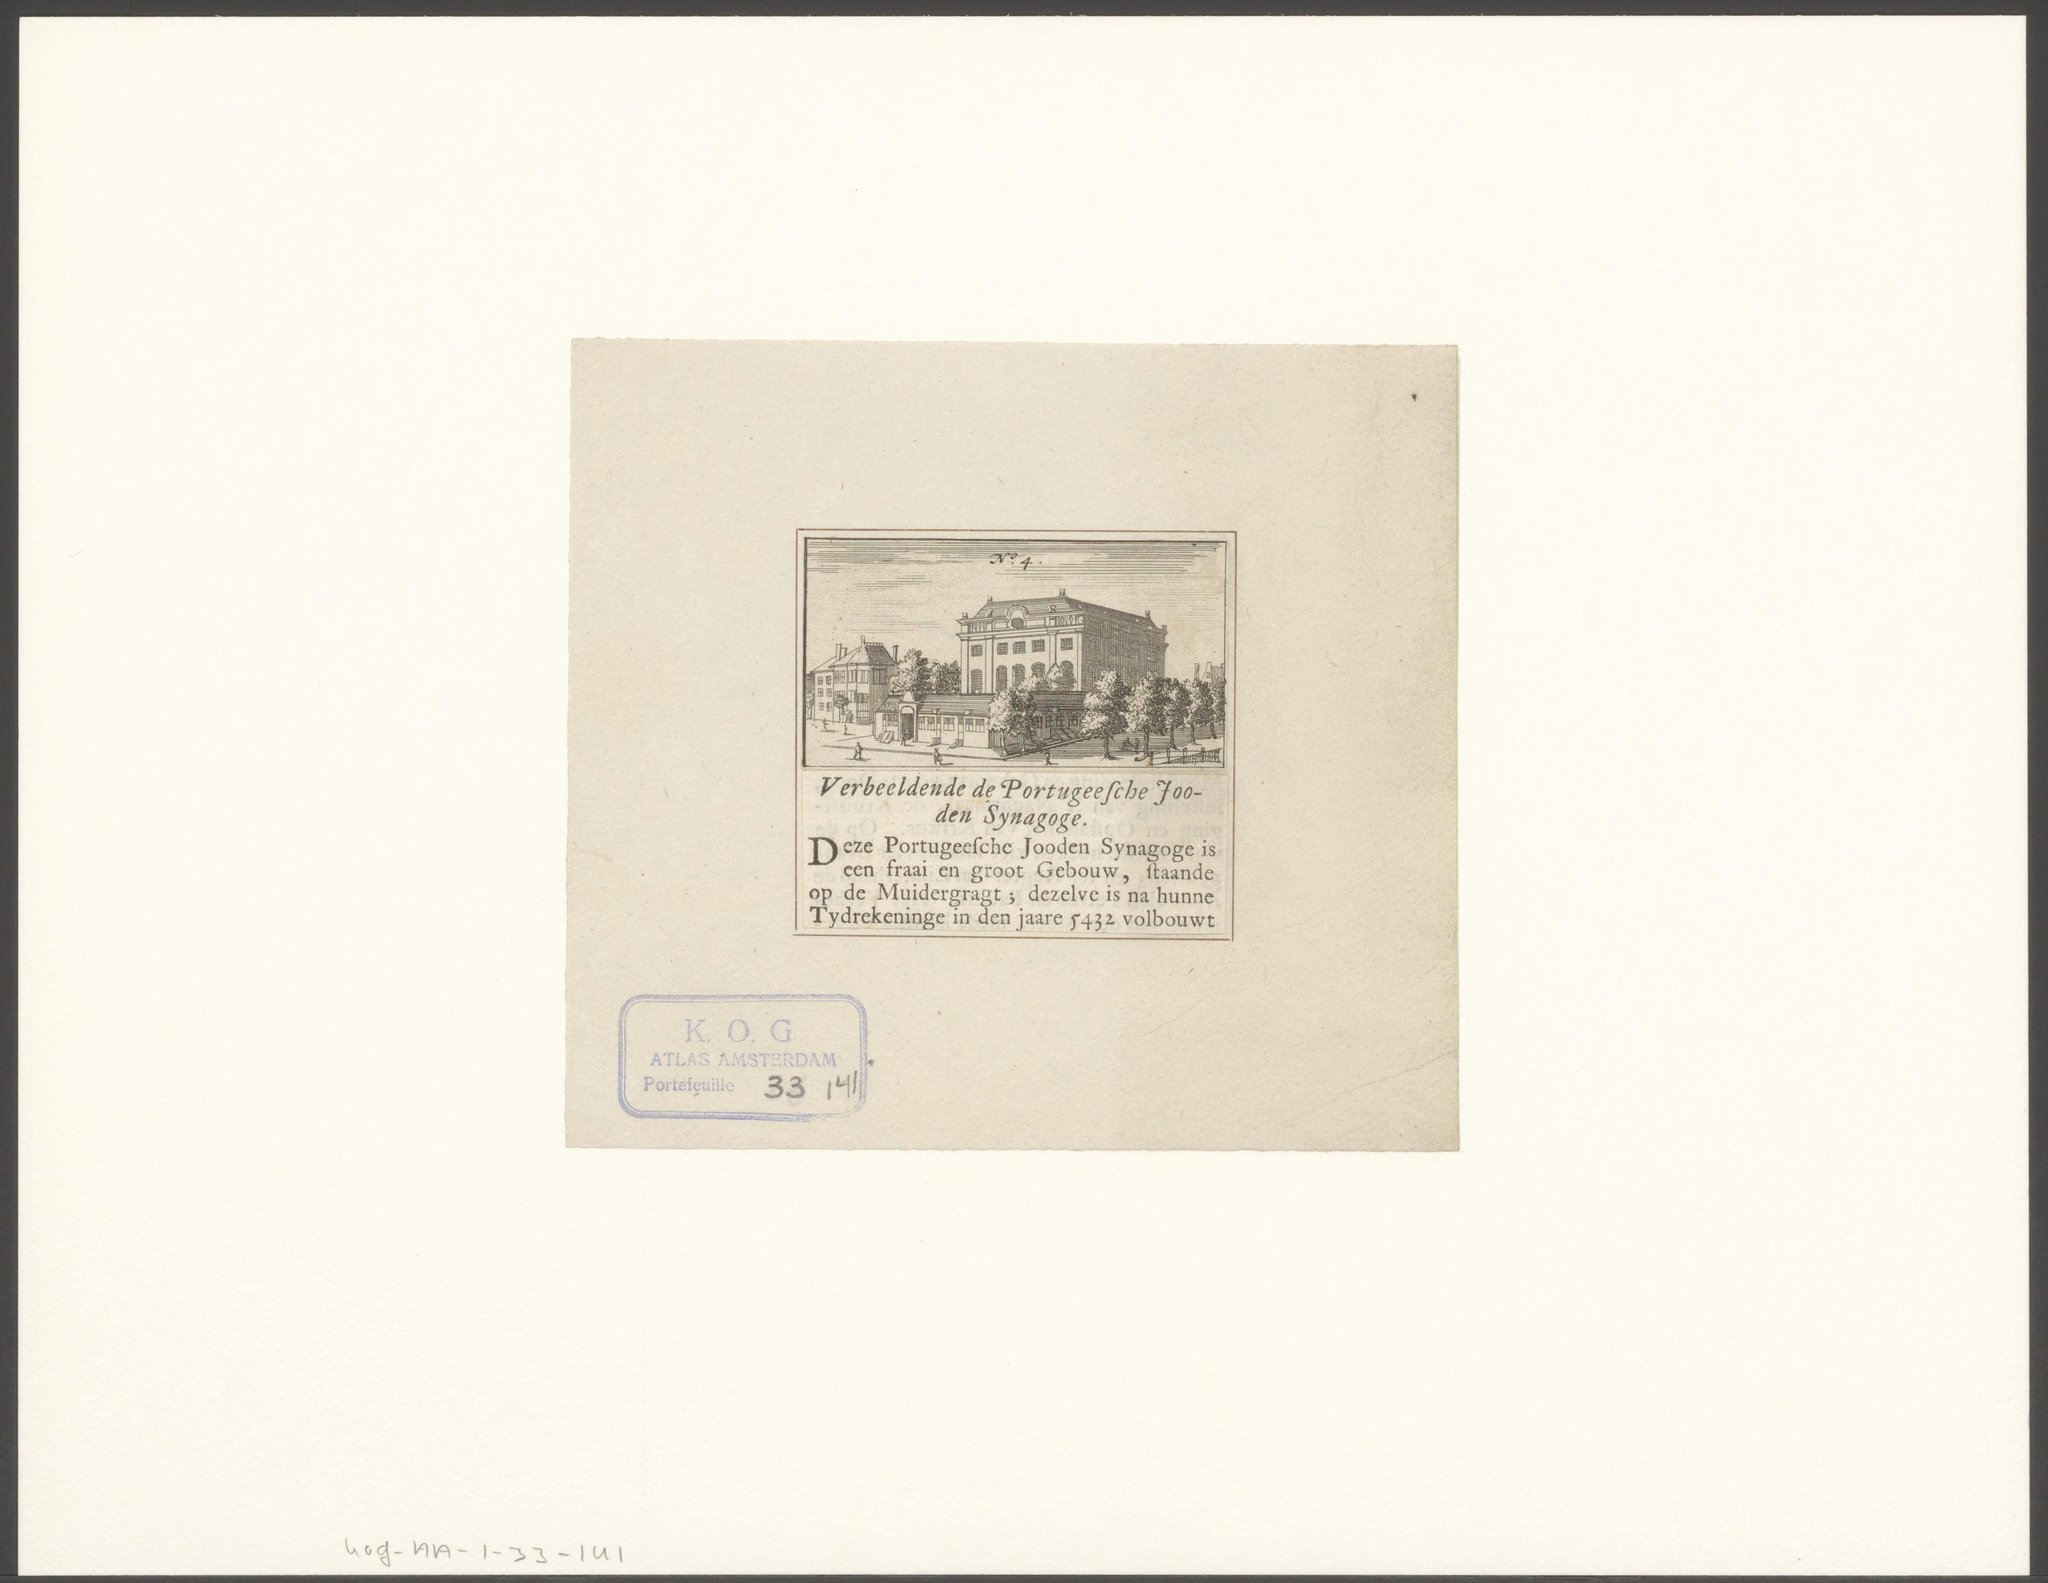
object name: print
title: Gezicht op de Portugese Synagoge te Amsterdam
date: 1736-1744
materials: paper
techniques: etching, letterpress printing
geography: amsterdam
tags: the synagogue (as building and place of worship ~ jewish religion), street (+ city(-scape) with figures, staffage)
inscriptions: collector's mark: Lugt 1641b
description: Centraal bovenaan genummerd: No. 4. Onder de prent is een verklarend bijschrift geplakt. Onderwerpsrubriek binnen de Atlas Amsterdam: Kerkwezen: Gebouwen diverse gemeenten: Portugees-Israëlitische Gemeente + rabbijnen.